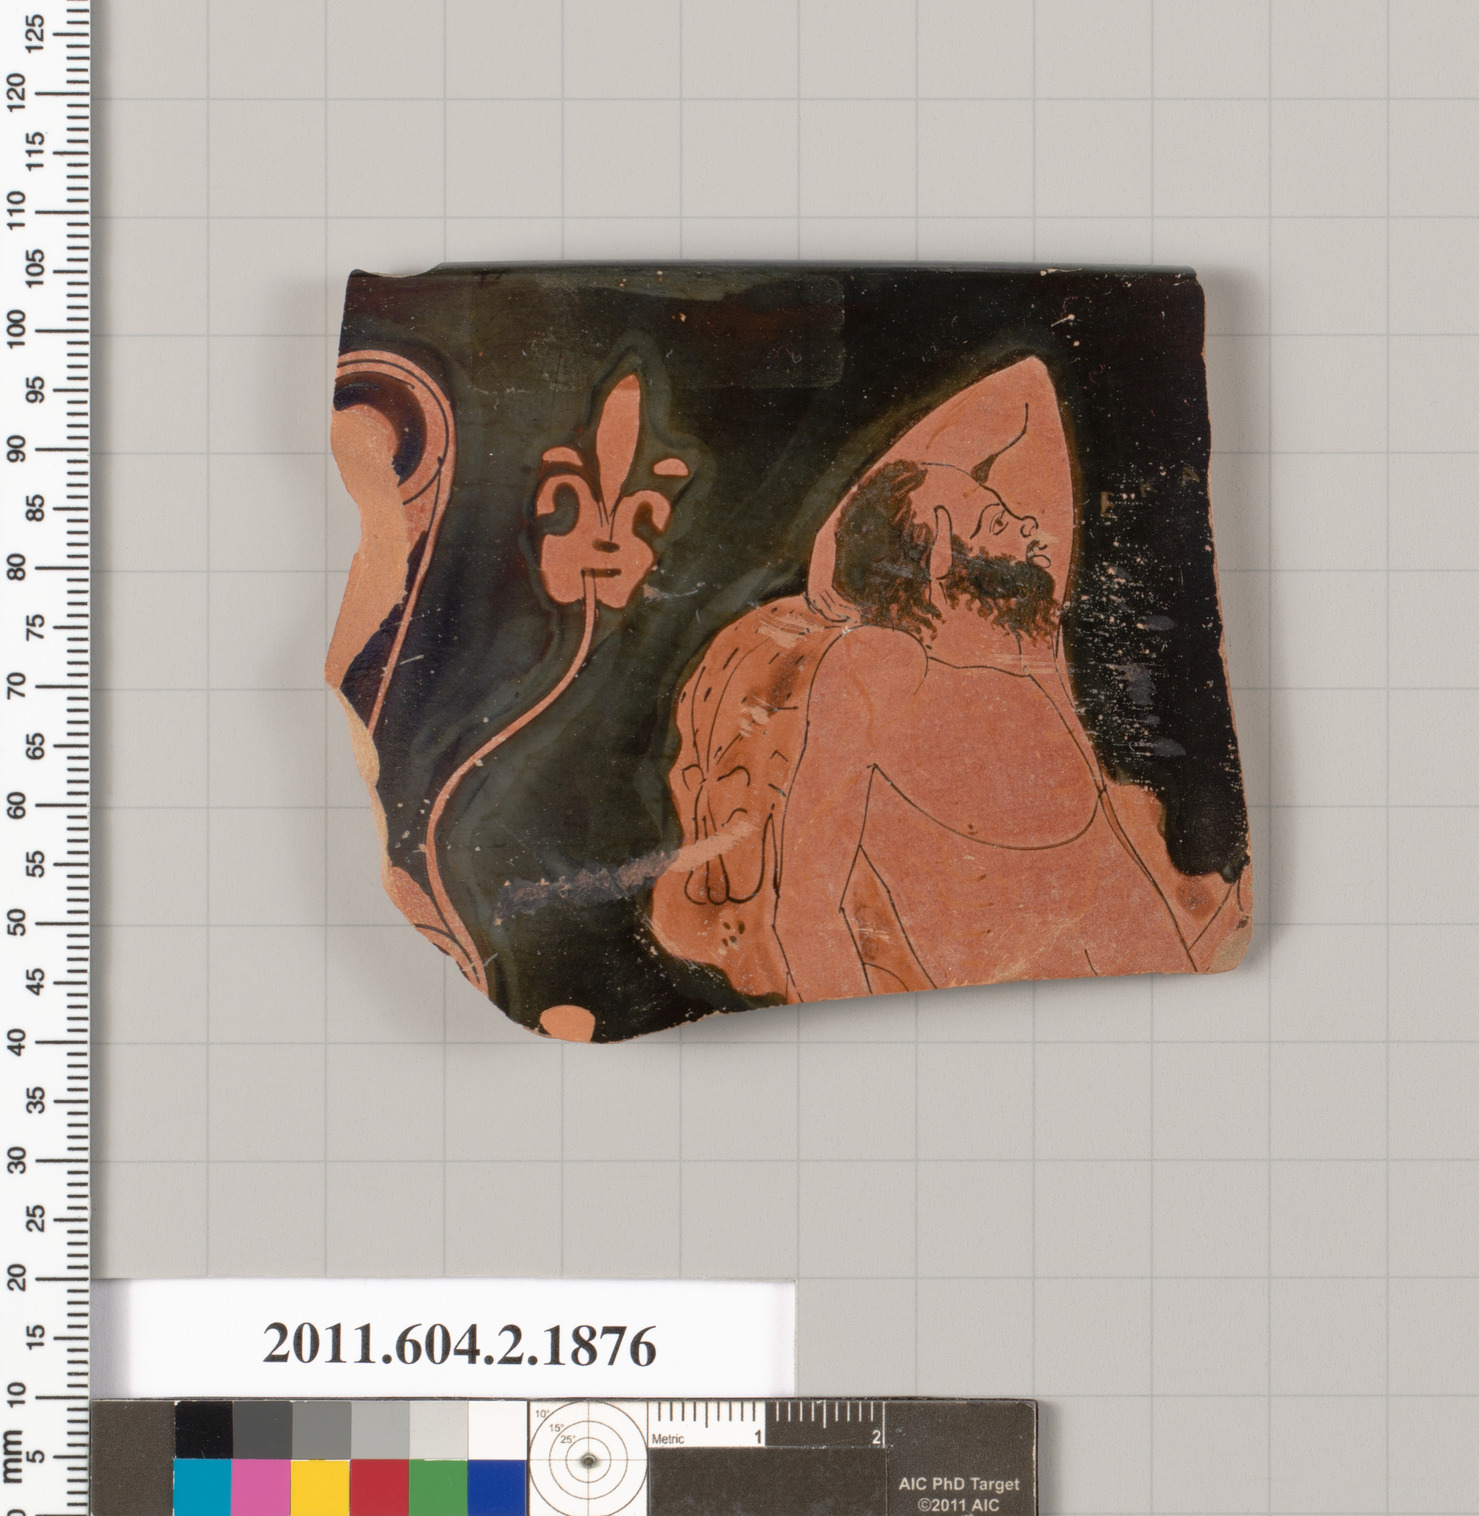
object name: skyphos fragment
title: Terracotta rim fragment of a skyphos (deep drinking cup)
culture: greek, attic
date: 450-426 BCE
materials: terracotta